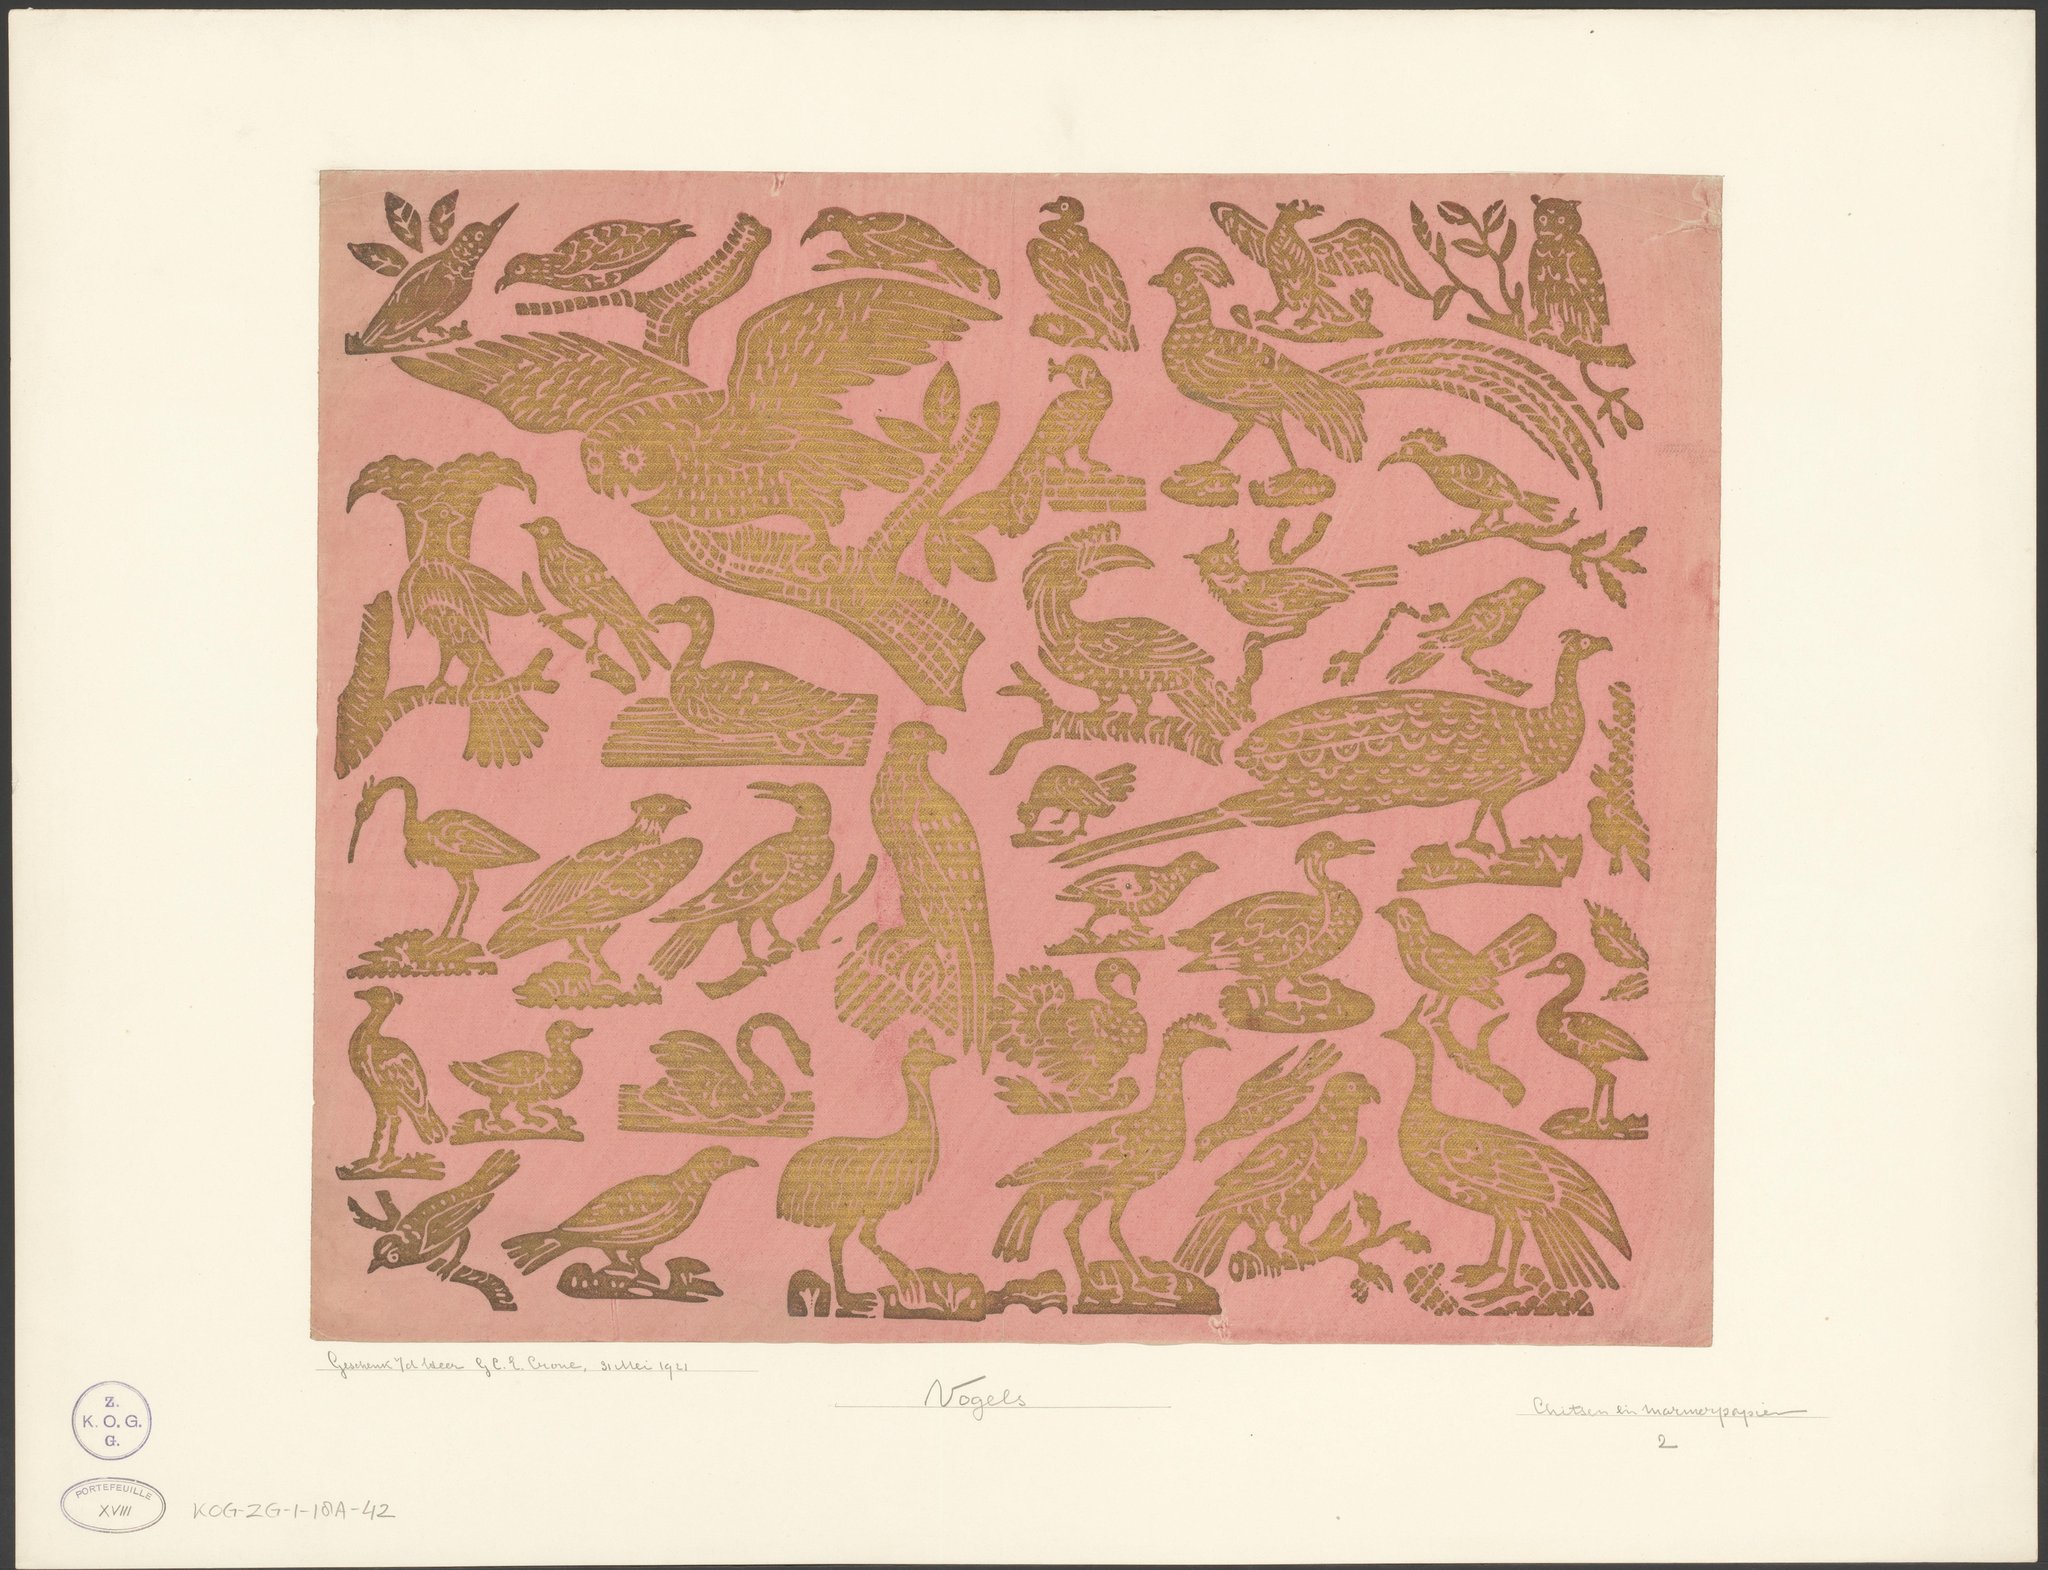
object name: brocade paper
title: Blad met een patroon van verschillende vogels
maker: Anonymous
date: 1750-1800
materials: gold leaf, paint, paper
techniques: relief print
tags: birds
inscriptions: stamp, collector's mark: Lugt 1641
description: Sierpapier met een patroon van verschillende vogels zoals de zwaan, uil en toekan. Onderwerpsrubrieken binnen de Atlas Zeden en Gewoonten: Schoone kunsten, Sitsen en marmerpapier.